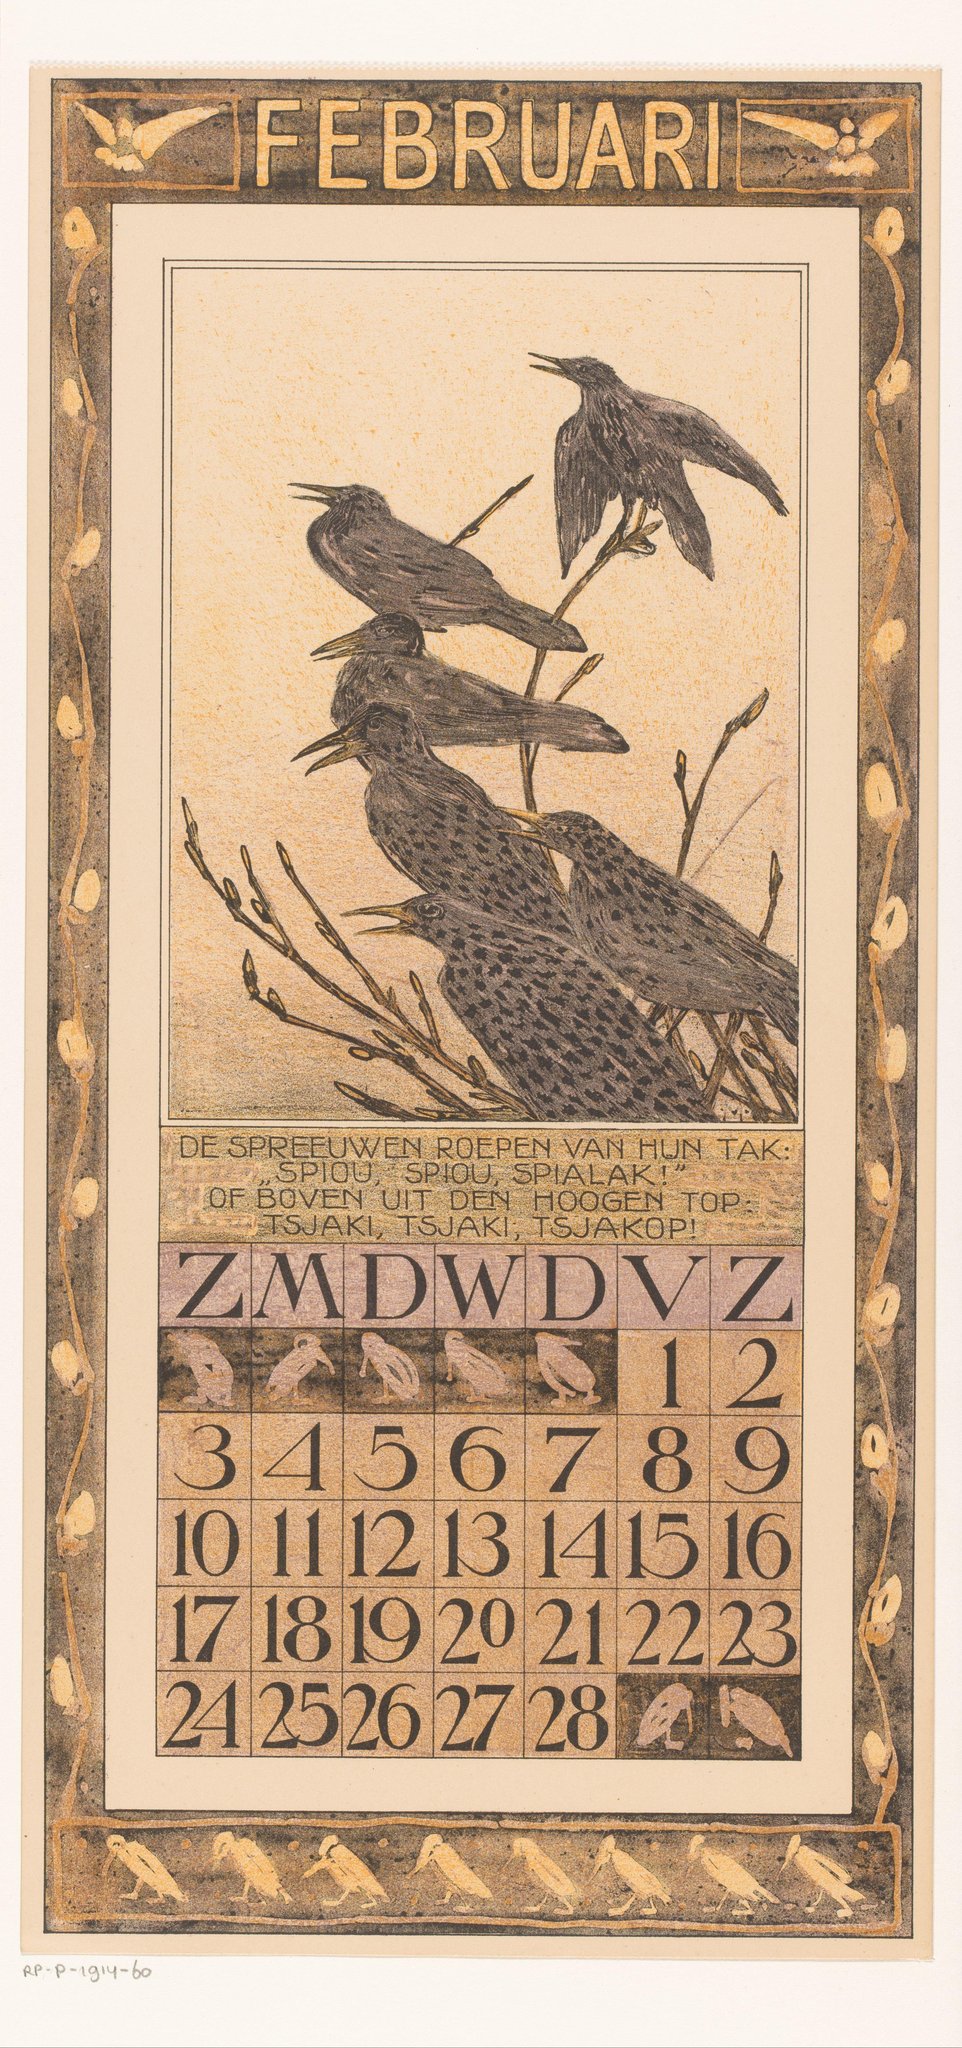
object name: print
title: Kalenderblad februari met spreeuwen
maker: theo van hoytema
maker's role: draughtsman, painter, print maker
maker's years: 1863-1917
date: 1906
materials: paper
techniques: lithograph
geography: amsterdam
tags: song-birds: starling, february ~ other concepts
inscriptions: collector's mark: Lugt 2228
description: De vogels zitten op takken. Bovenaan het blad een scheurlijn.